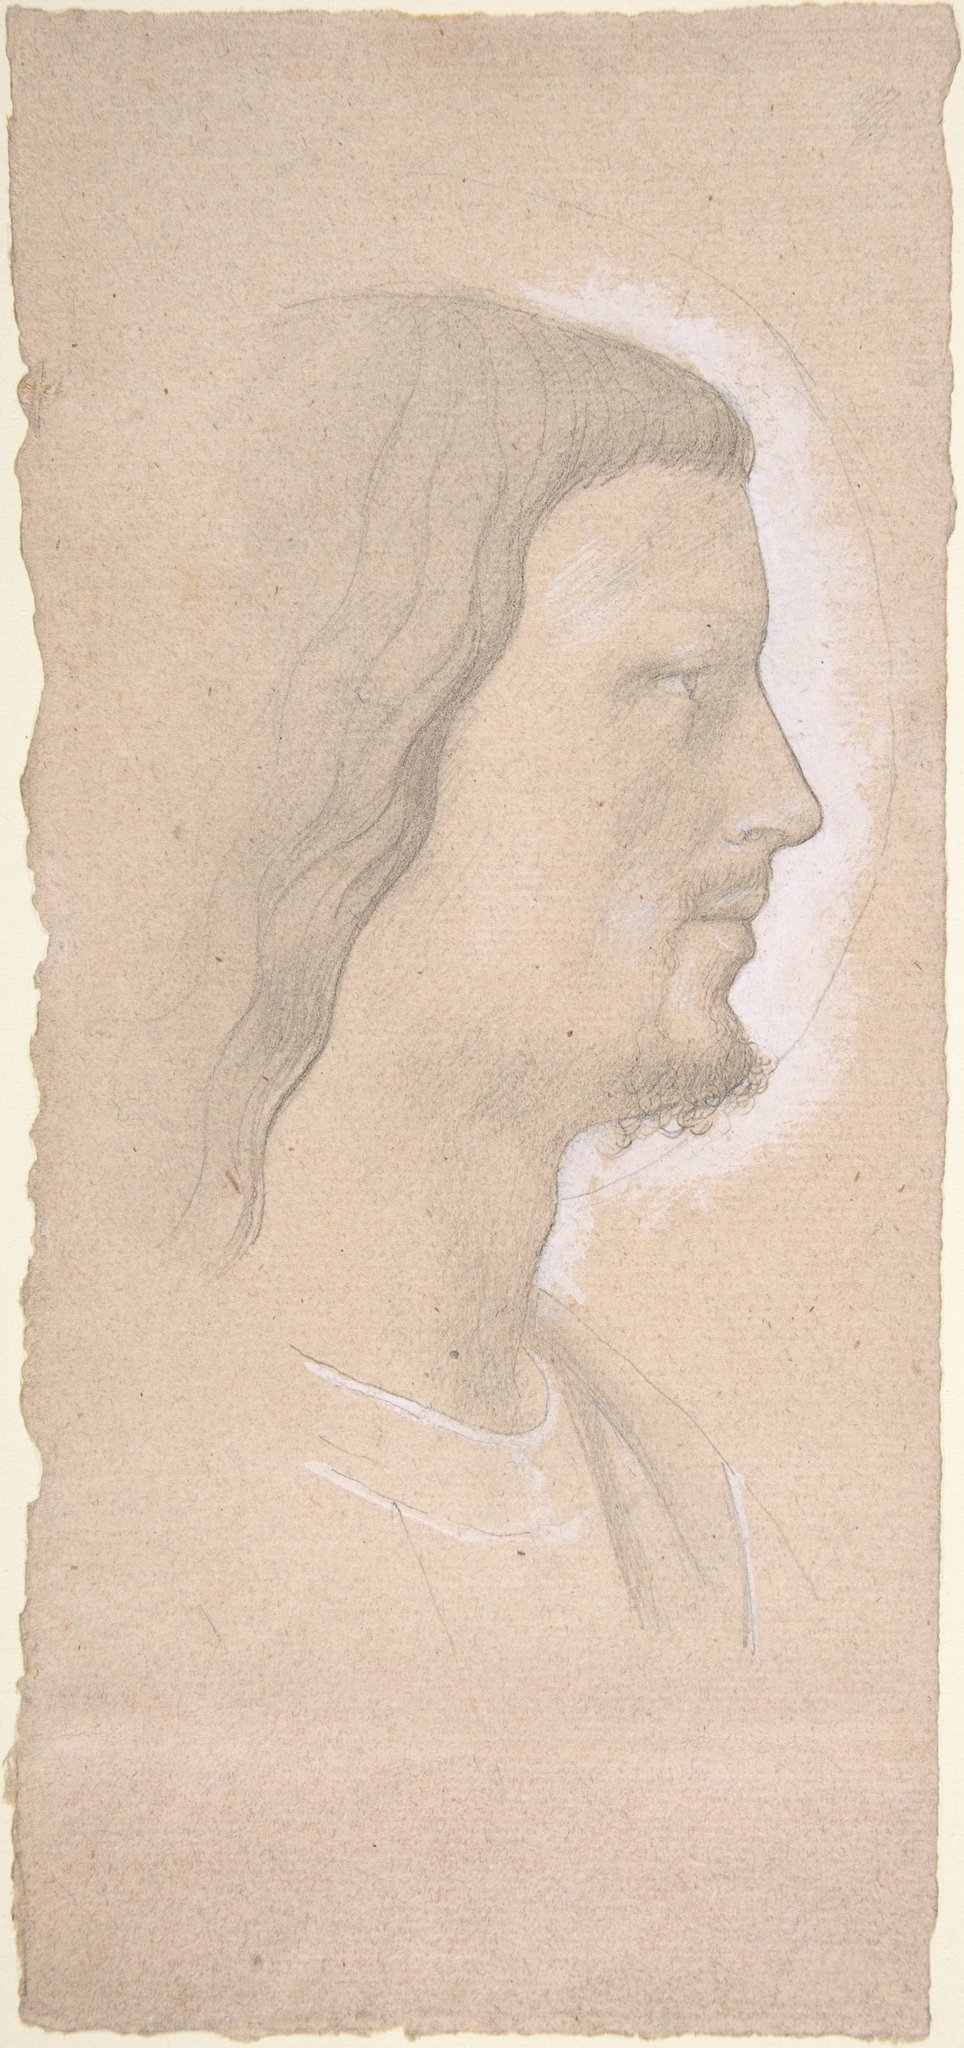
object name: drawing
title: Head of a Saint (profile to the right), after Fra Angelico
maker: edgar degas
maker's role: artist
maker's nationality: french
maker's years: 1834-1917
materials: chalk, paper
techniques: heightening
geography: france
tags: men,profiles,saints